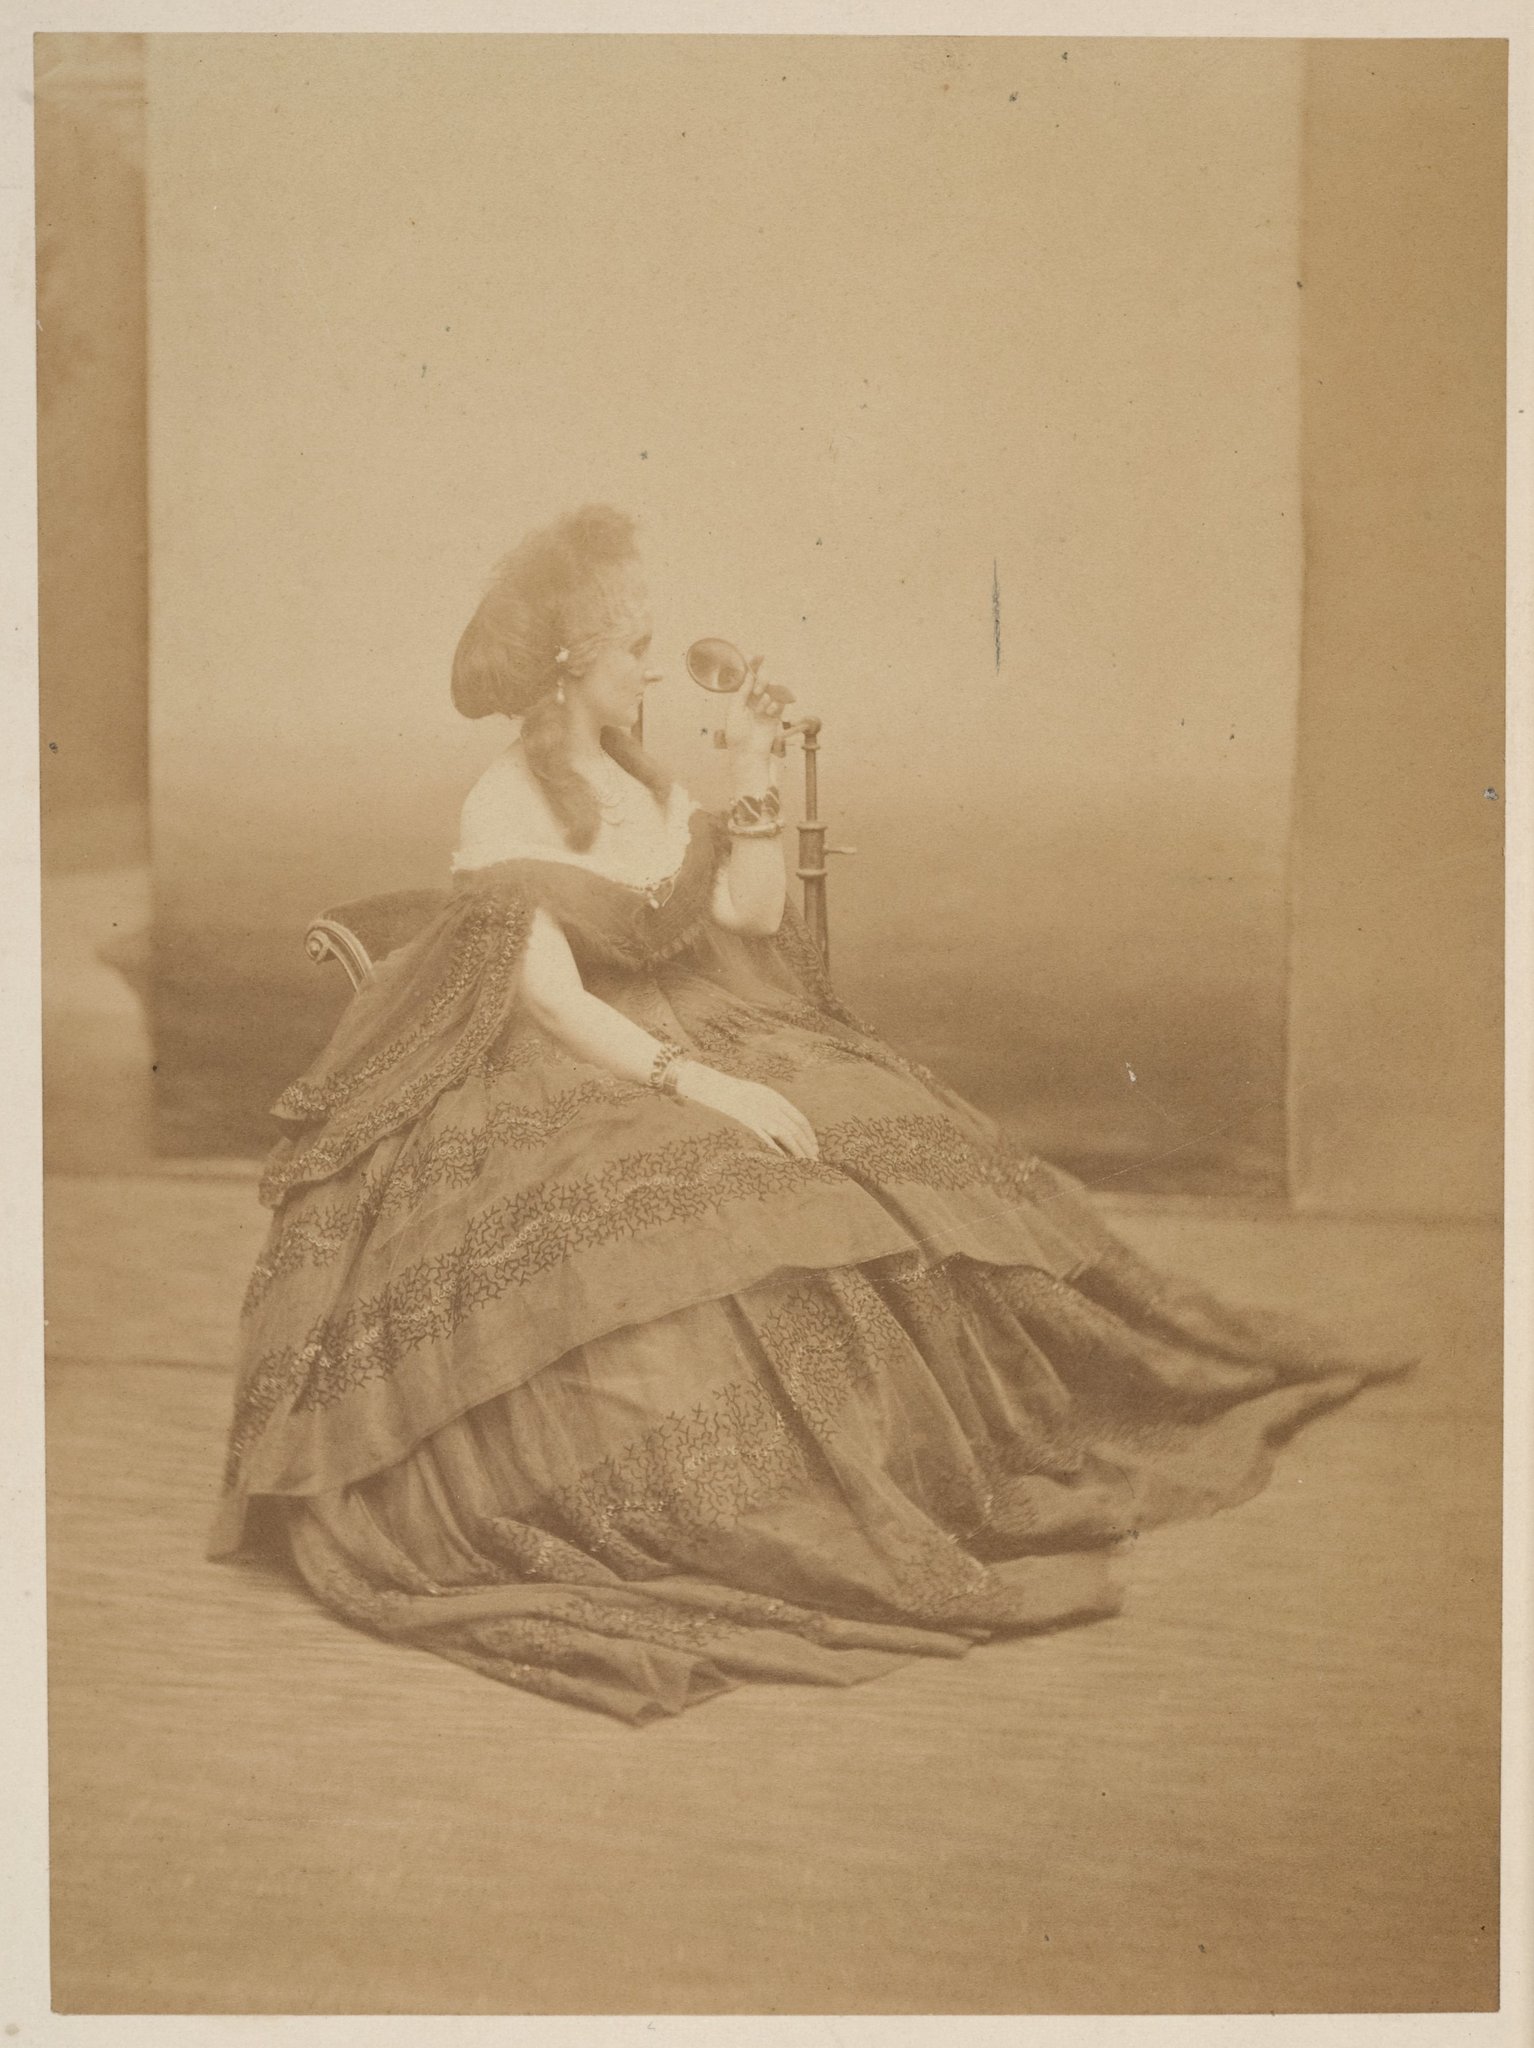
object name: photograph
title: Les yeux mirés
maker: pierre-louis pierson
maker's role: artist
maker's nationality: french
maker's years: 1822-1913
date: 1860-1869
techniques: albumen silver print, glass negative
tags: portraits,women,mirrors